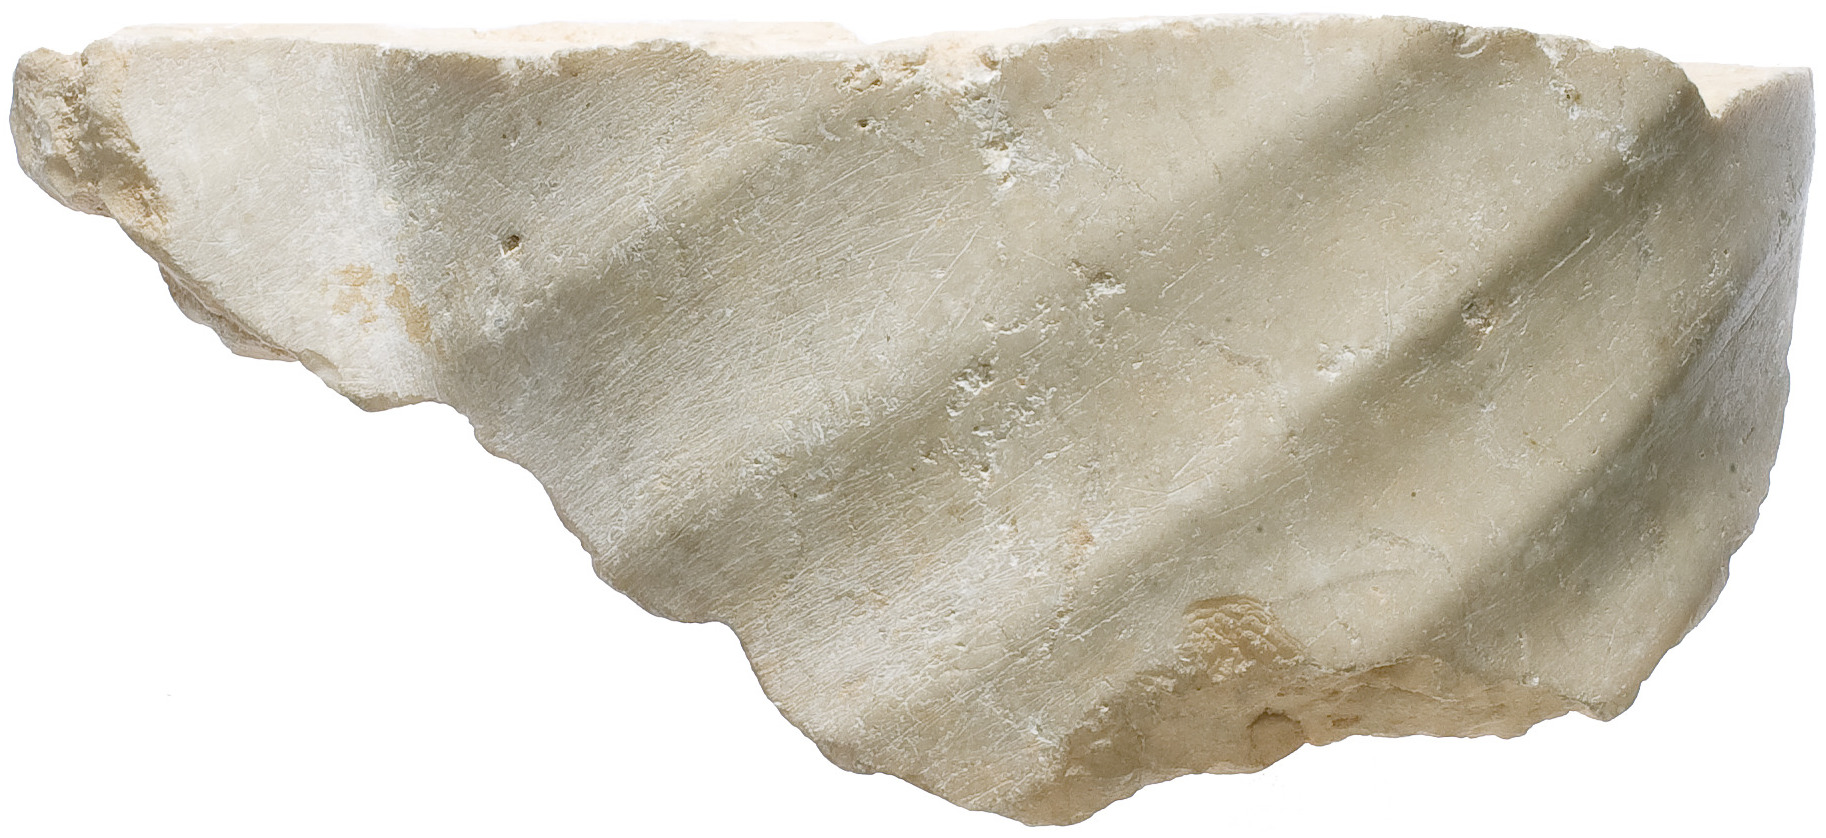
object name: leg, with pleated garment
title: Leg (?), with pleated garment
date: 1353-1336 BCE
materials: limestone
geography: egypt